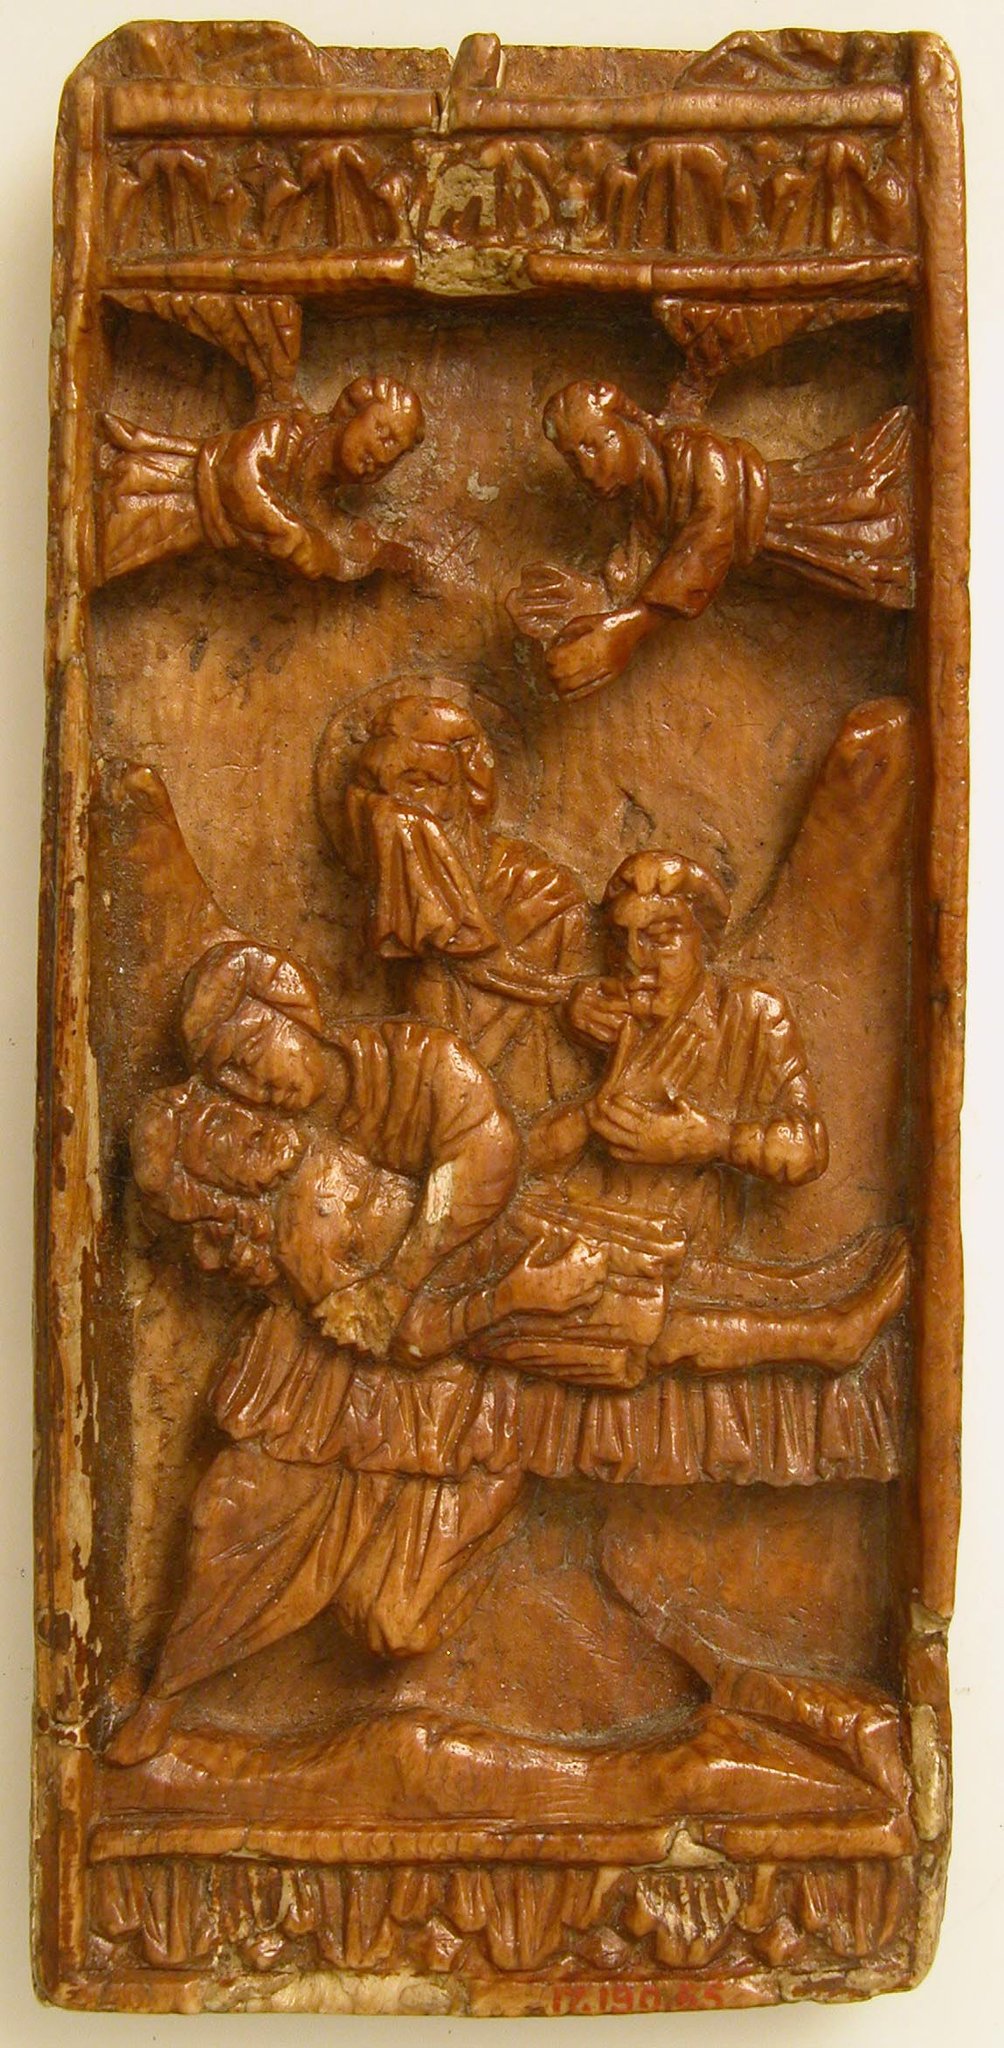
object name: plaque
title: Icon of the Lamentation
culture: byzantine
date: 1101-1300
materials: ivory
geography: venice or ?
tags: men,angels,christ